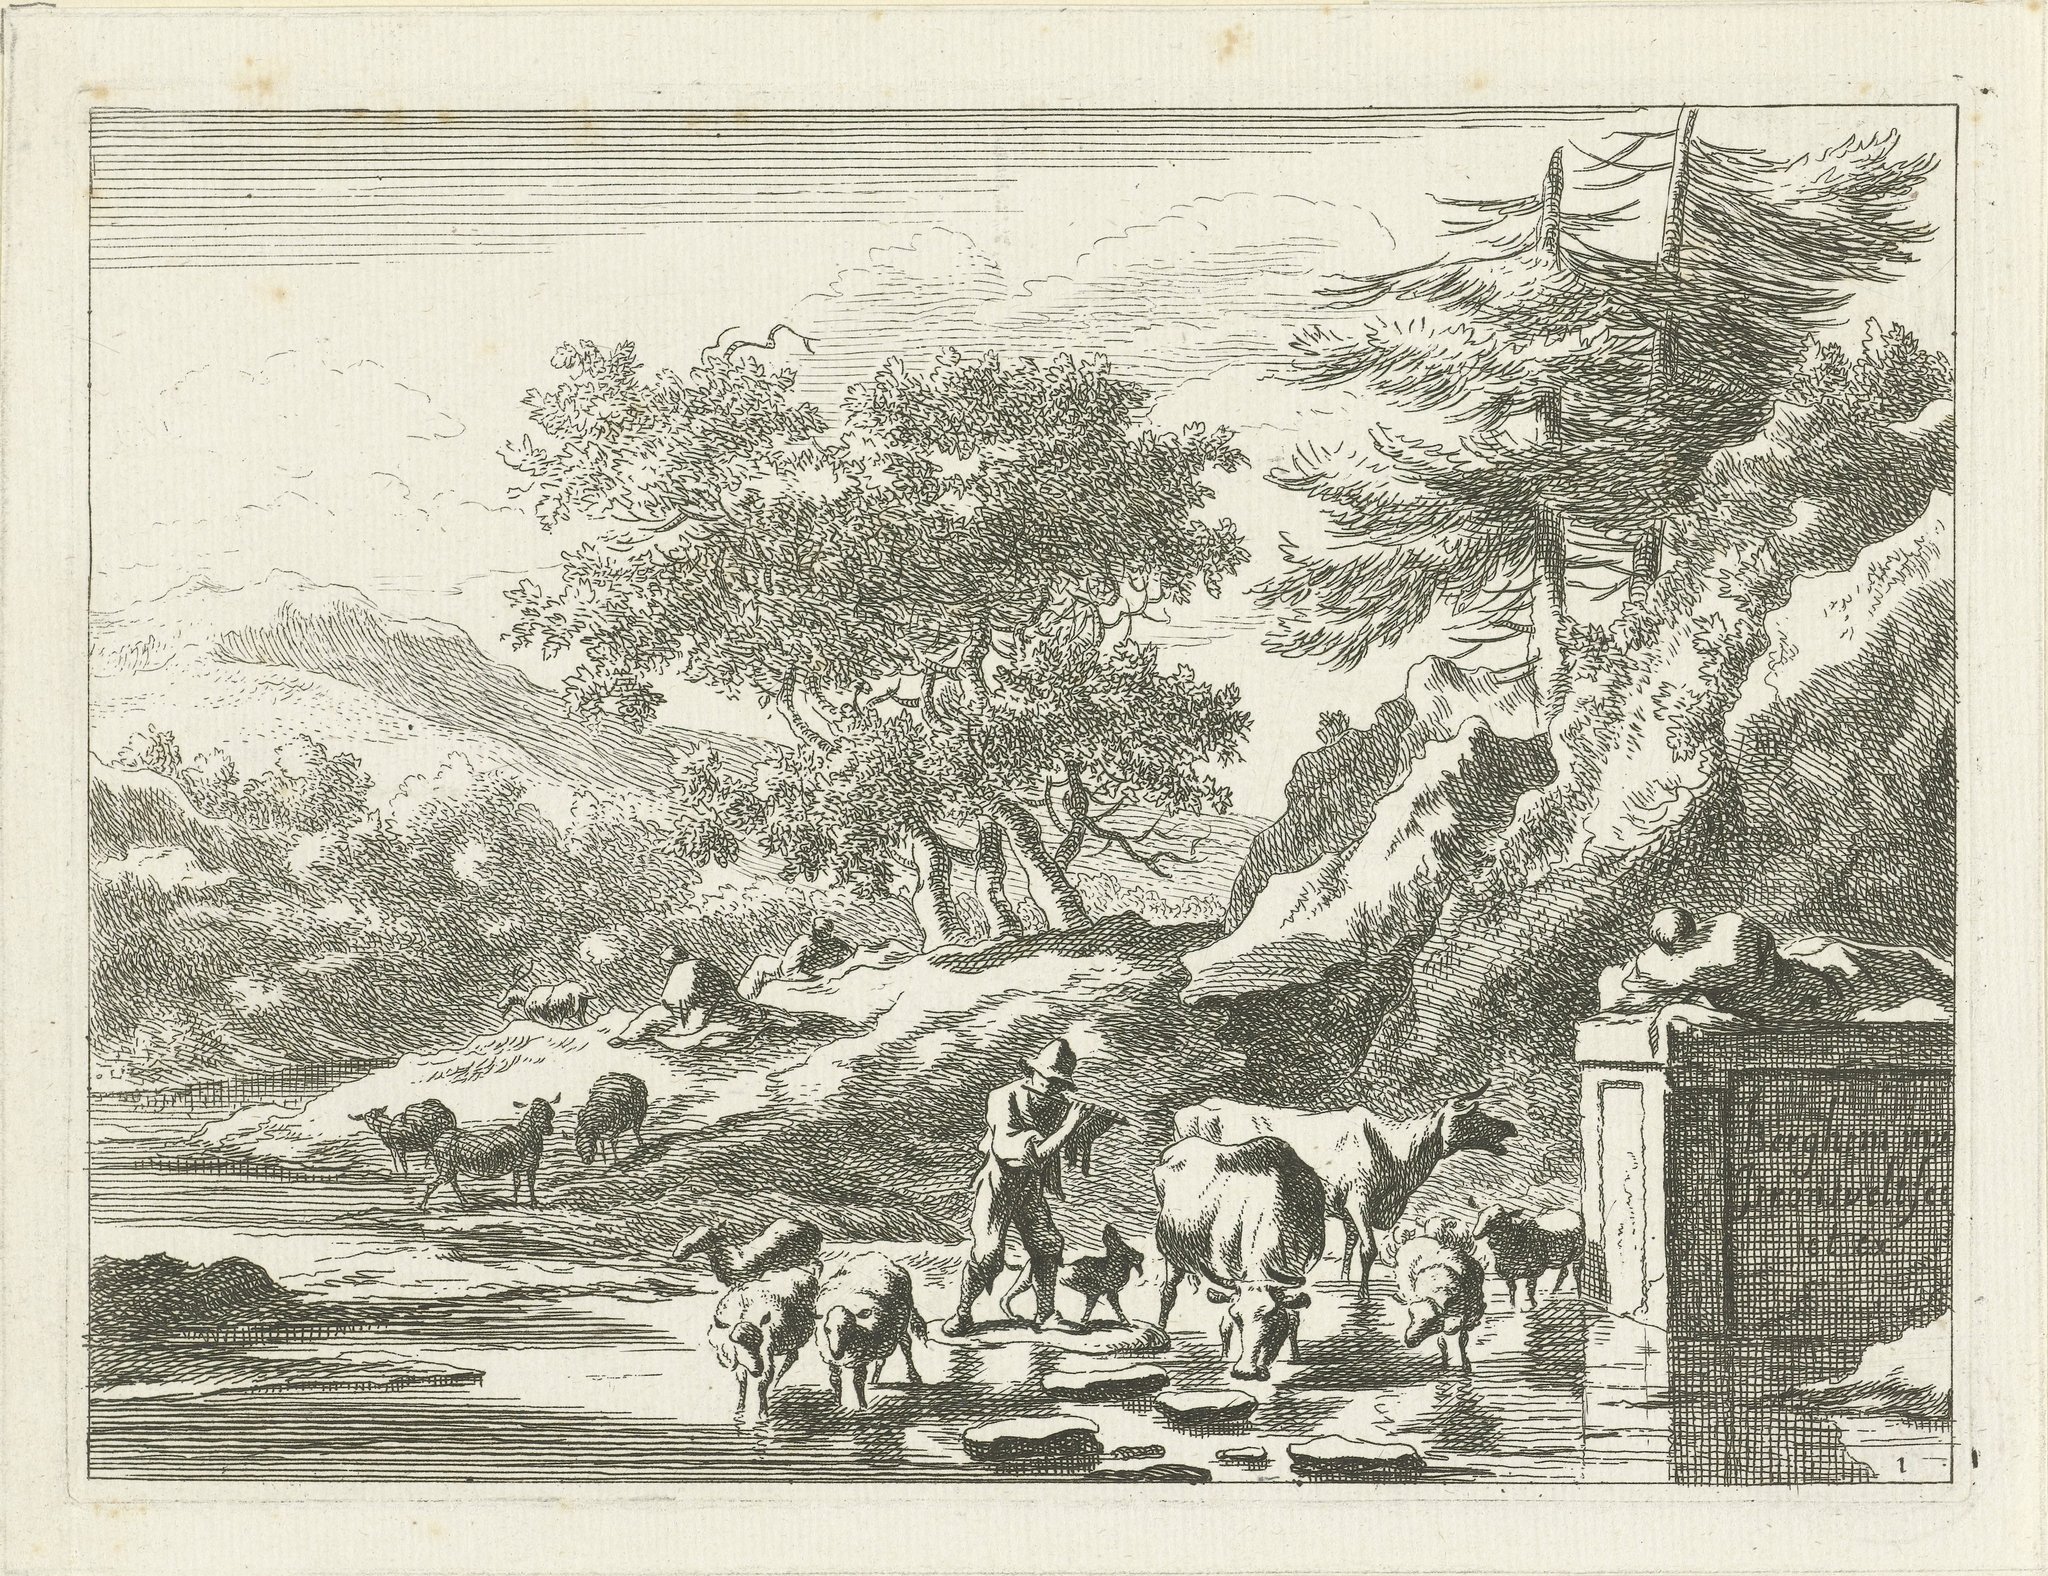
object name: print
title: Landschap met herders en vee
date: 1679-1728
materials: paper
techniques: engraving, etching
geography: amsterdam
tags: landscapes (+ landscape with figures, staffage), groups of animals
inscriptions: collector's mark: Lugt 240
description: Heuvelachtig landschap met fluitspelende herder tussen zijn vee staand in een beek. Links op de achtergrond twee op een heuvel liggende figuren en wat vee. Rechts klassiek ogend beeld op sokkel met daarop de namen van de kunstenaars. Eerste prent uit een serie van zes met landschappen met herders en vee.